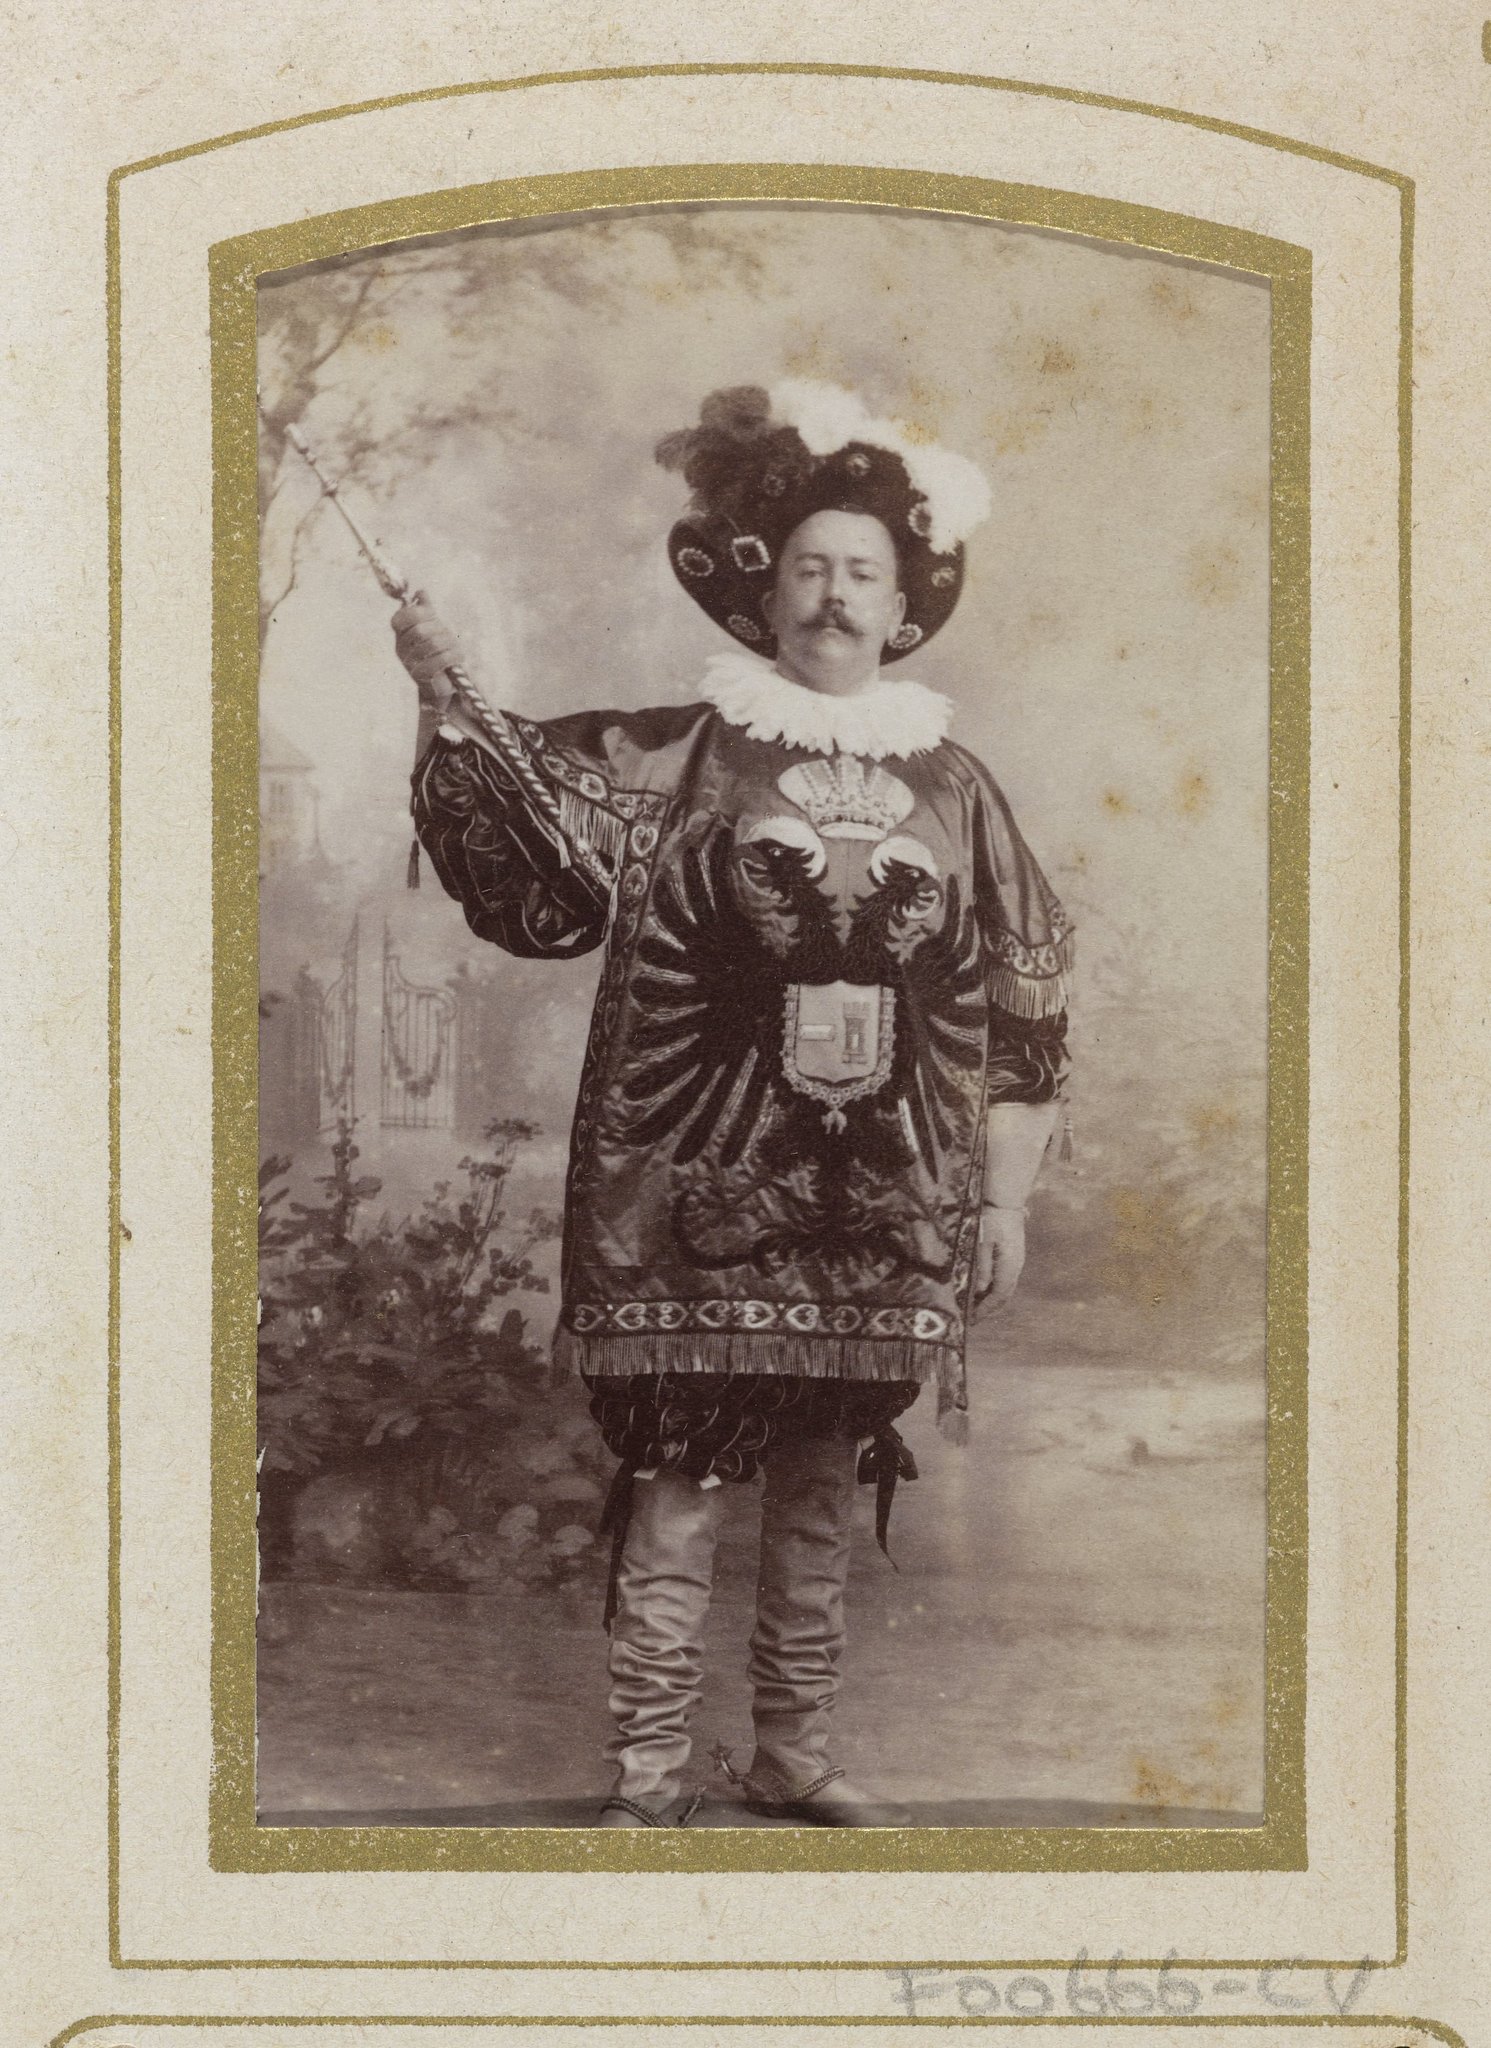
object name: carte de visite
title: Portret van een jonge man in kostuum met staf, aangeduid als J. Veder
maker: antonius joannes van der stok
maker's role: fotograaf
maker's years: 1862-1941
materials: cardboard, photographic support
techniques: albumen print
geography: leiden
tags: walking-stick, staff, historical persons, historical costume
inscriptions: name: ‘J. Veder./ 221.’, inscription: ‘Ant. J. van der Stok/ PHOTOGRAPHE/ Leiden Rapenburg 13.’